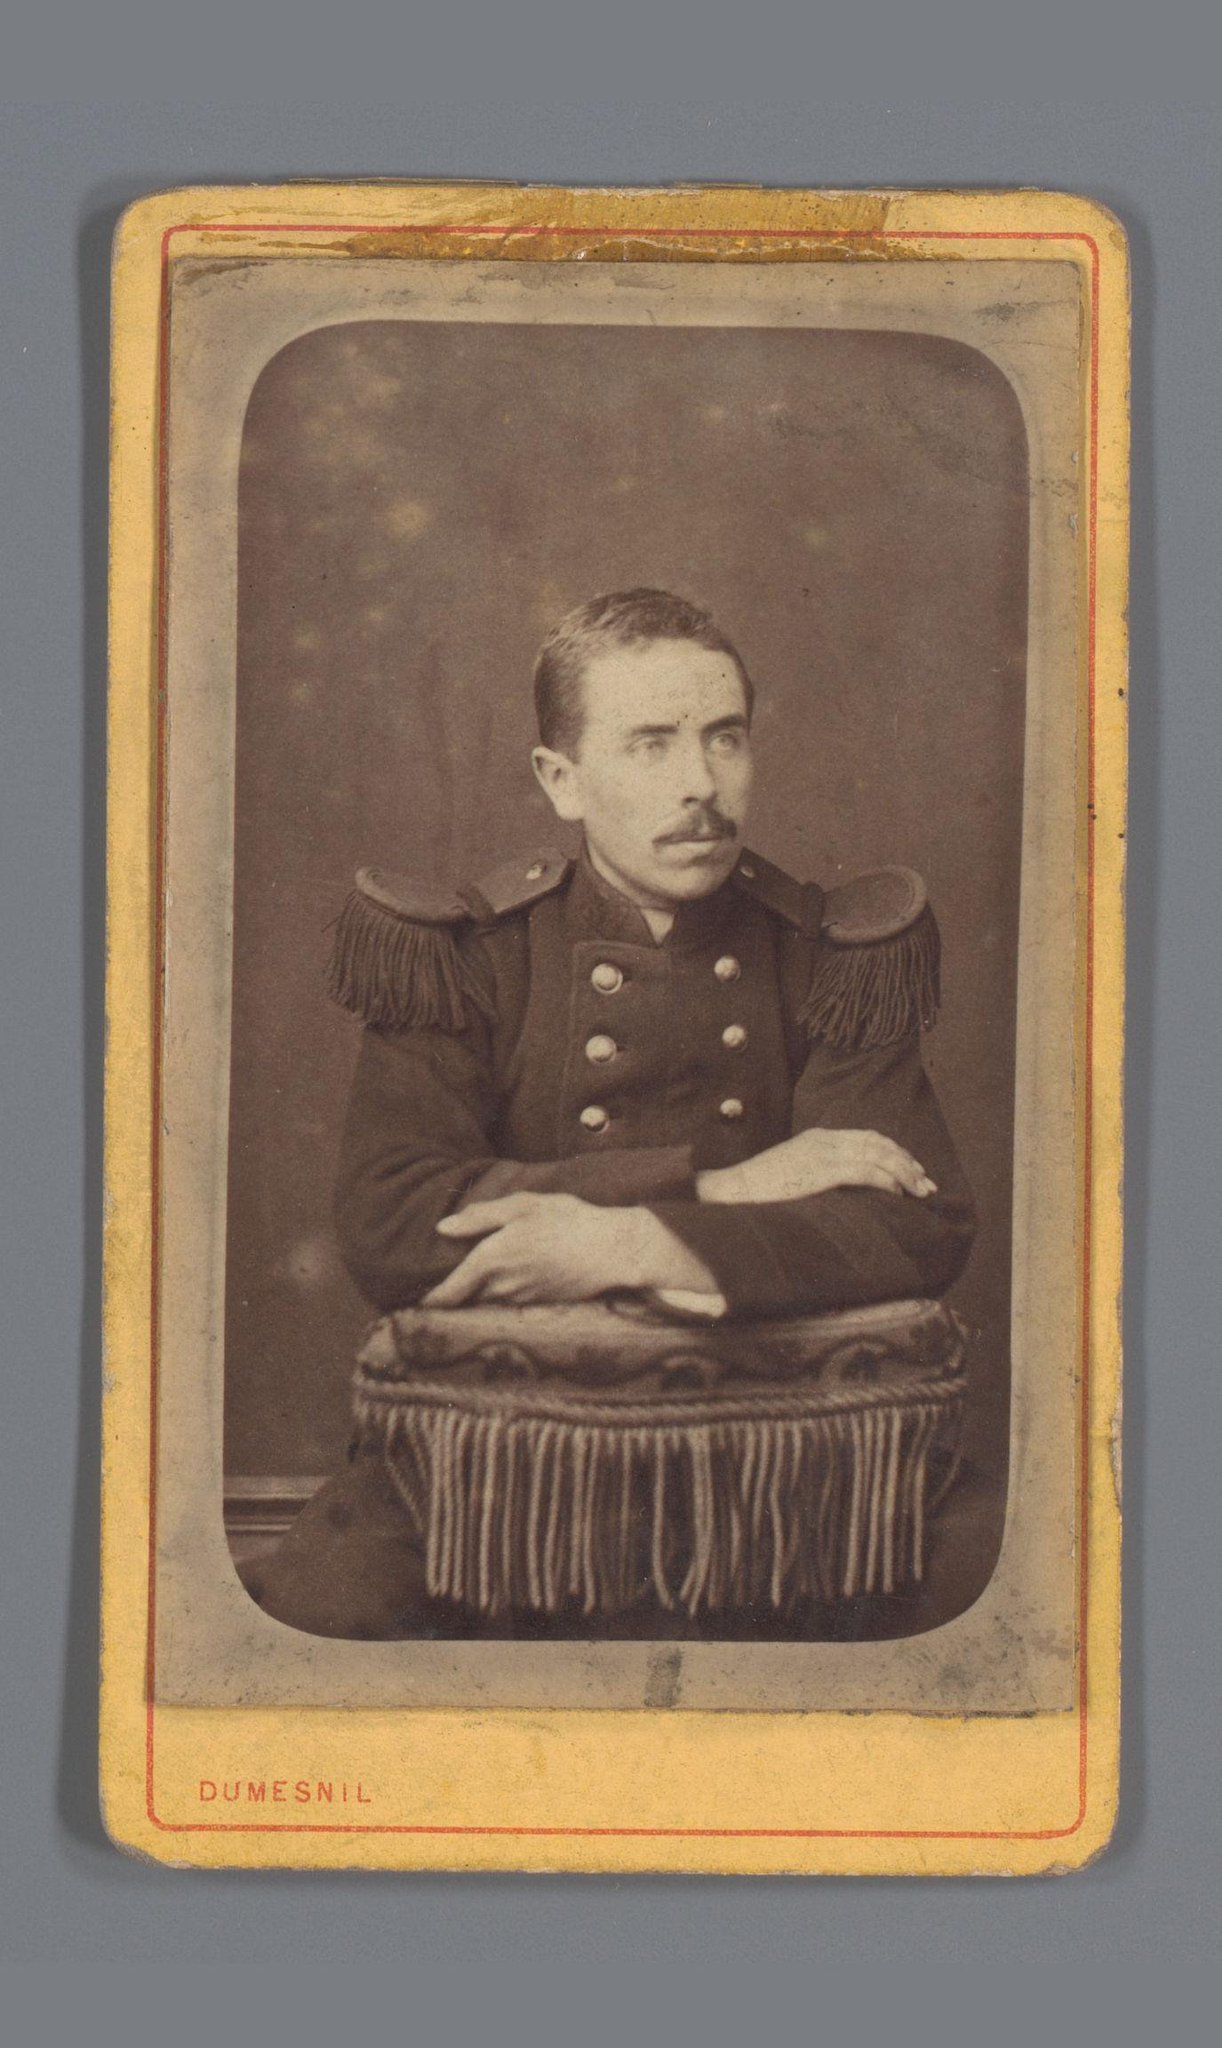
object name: photograph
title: Portret van een onbekende man in uniform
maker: alphonse charles dumesnil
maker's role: fotograaf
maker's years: 1836-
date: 1881-1886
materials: cardboard, celluloid, paper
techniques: albumen print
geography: melun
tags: adult man, anonymous historical person portrayed, (military) uniforms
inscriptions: address: ‘19. Rue de Bourgogne, 19/ près la Place St Jean/ MELUN’, inscription: ‘Photographie Parisienne/ Les Clichés sont conservés’